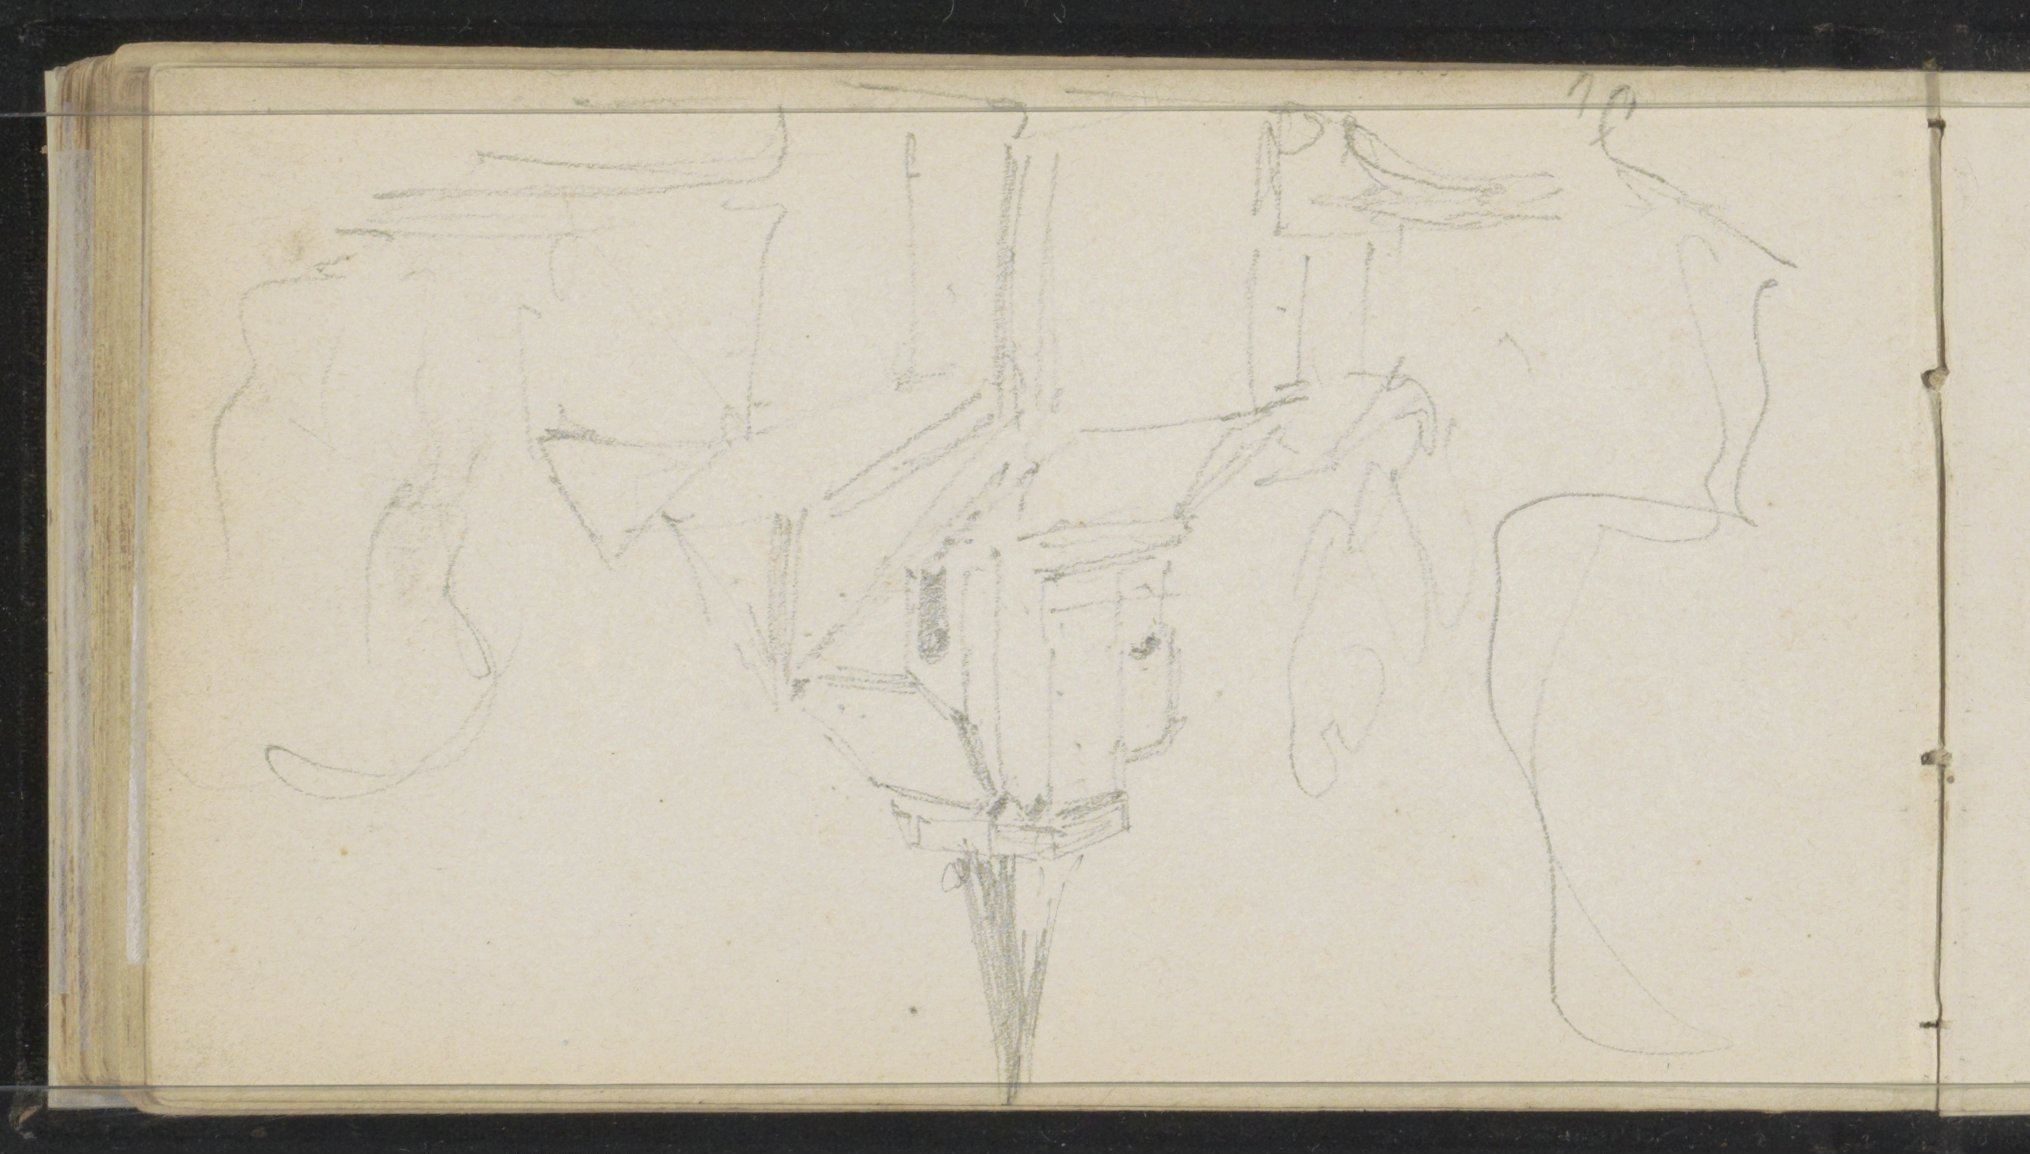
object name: sketchbook leaf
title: Gezicht op een kerk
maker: cornelis springer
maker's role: draughtsman, painter, print maker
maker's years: 1817-1891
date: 1860-1866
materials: paper, pencil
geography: netherlands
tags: city-view, and landscape with man-made constructions, church (exterior)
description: Gezicht op een kerk. Links en rechts bomen. Blad 43 verso uit een schetsboek met 44 bladen.